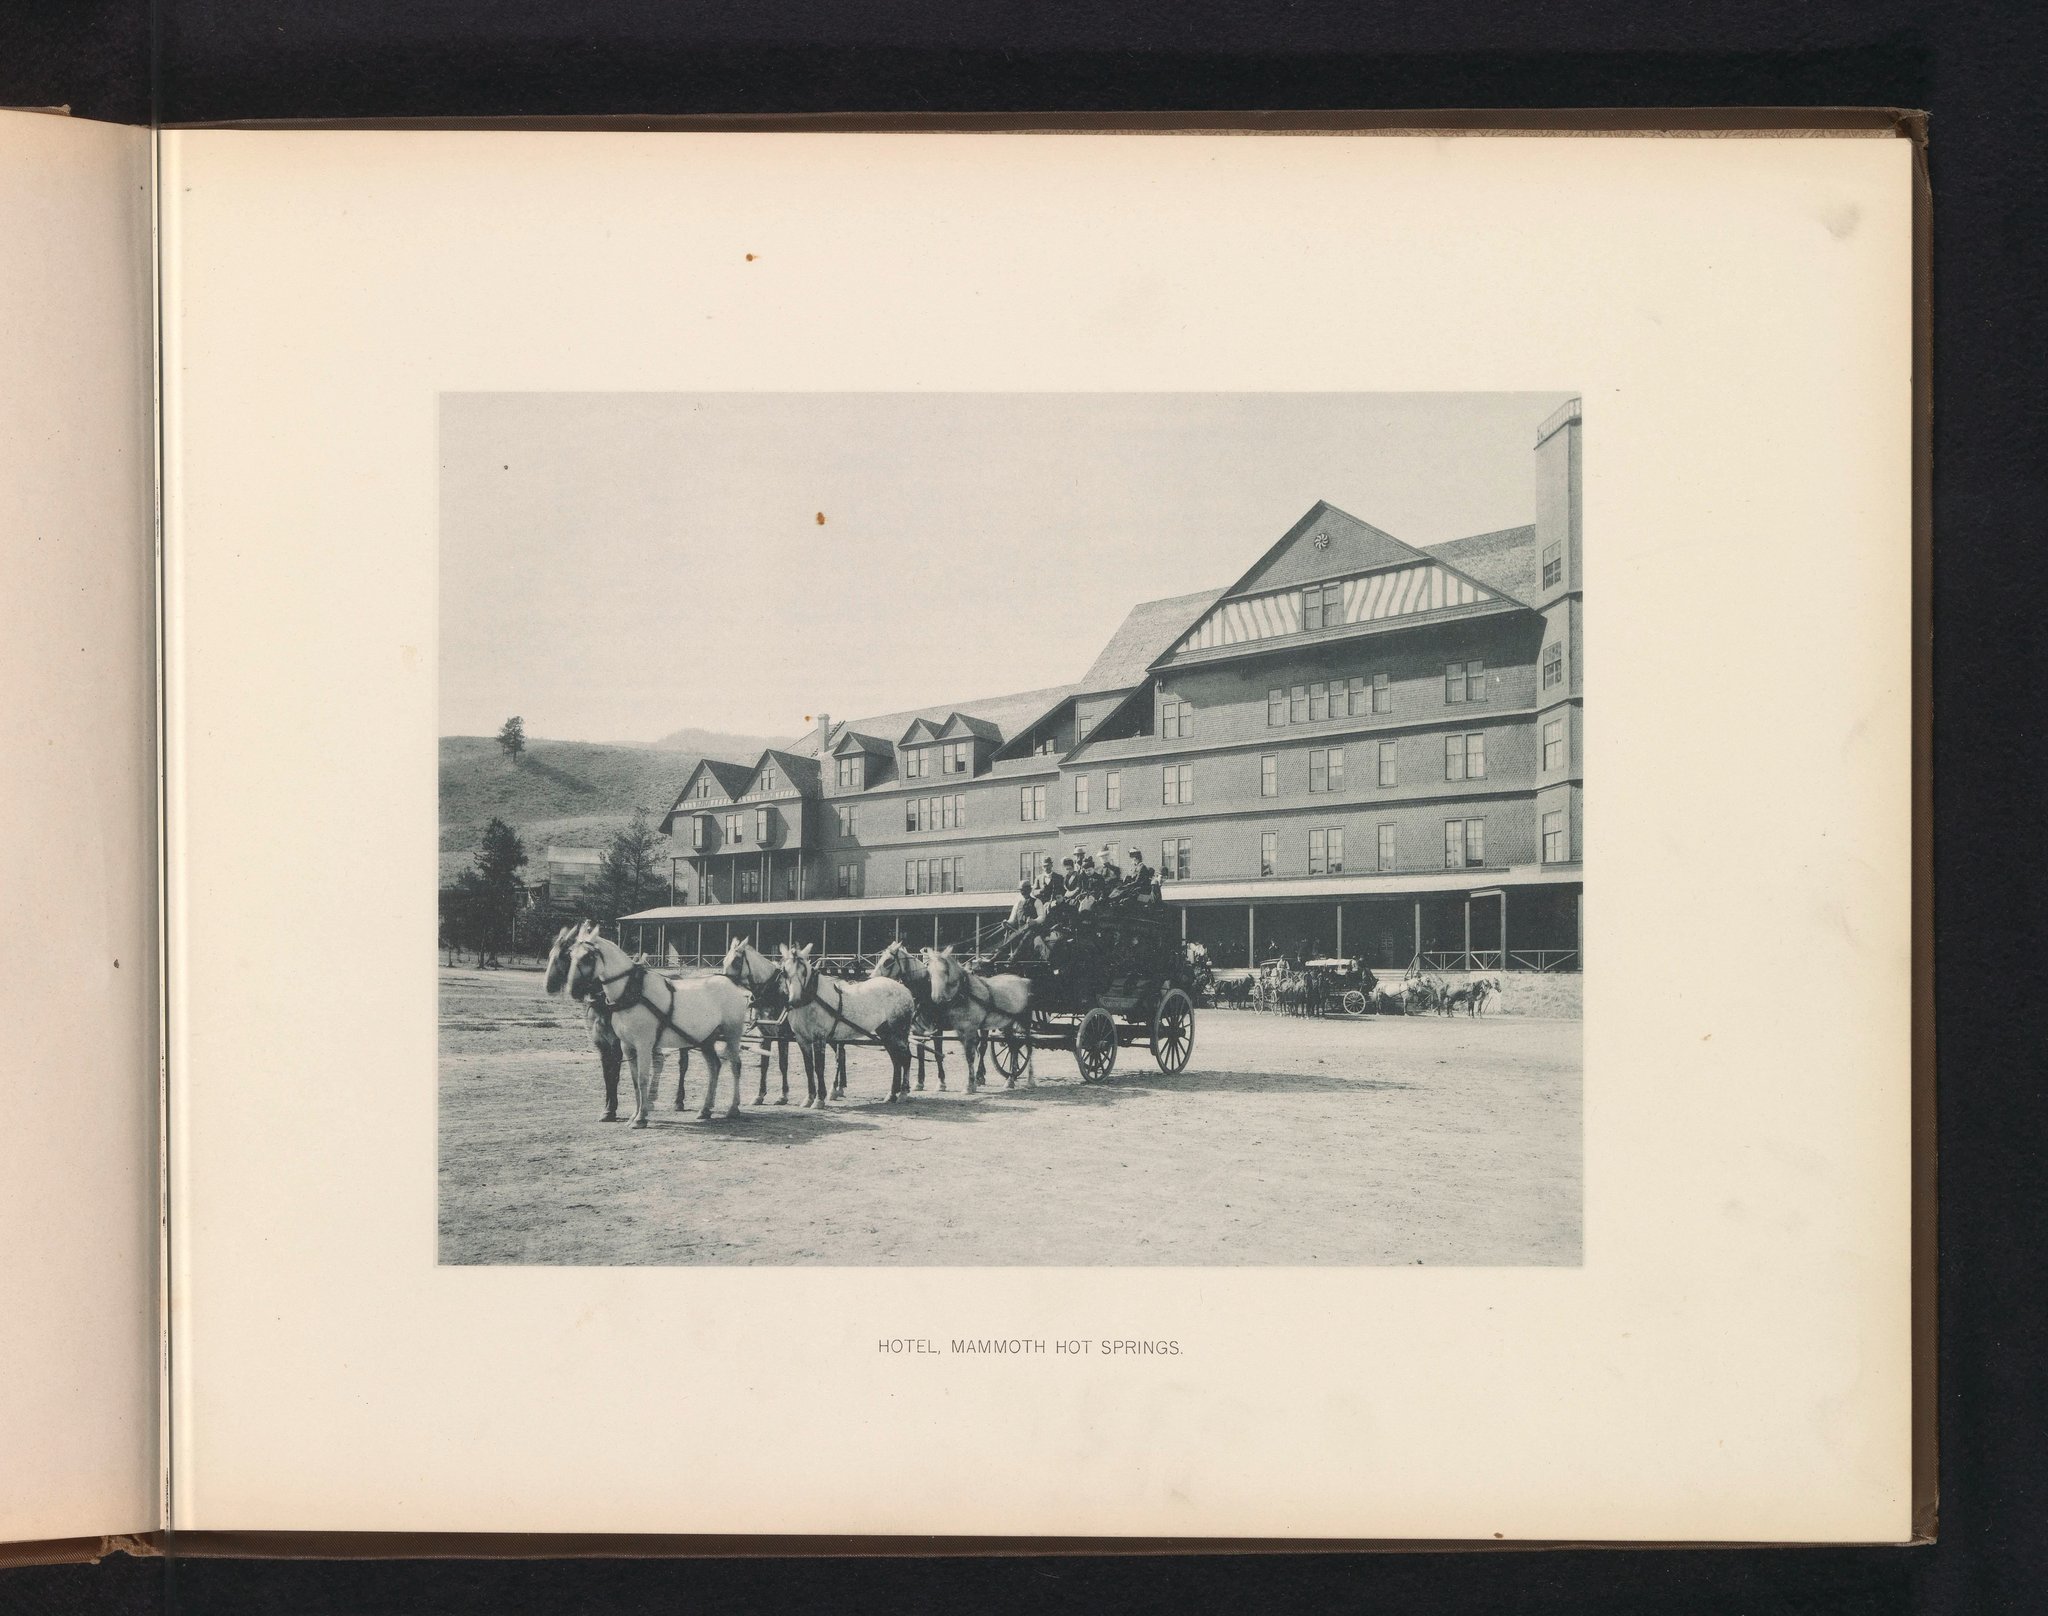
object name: photomechanical print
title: Hotel mammoth hot springs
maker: frank jay haynes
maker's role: fotograaf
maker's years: 1853-1921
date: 1886-1891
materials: paper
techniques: photograph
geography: yellowstone national park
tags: four-wheeled, animal-drawn vehicle, e.g.: cab, carriage, coach, façade (of house or building), hotel, hostelry, inn